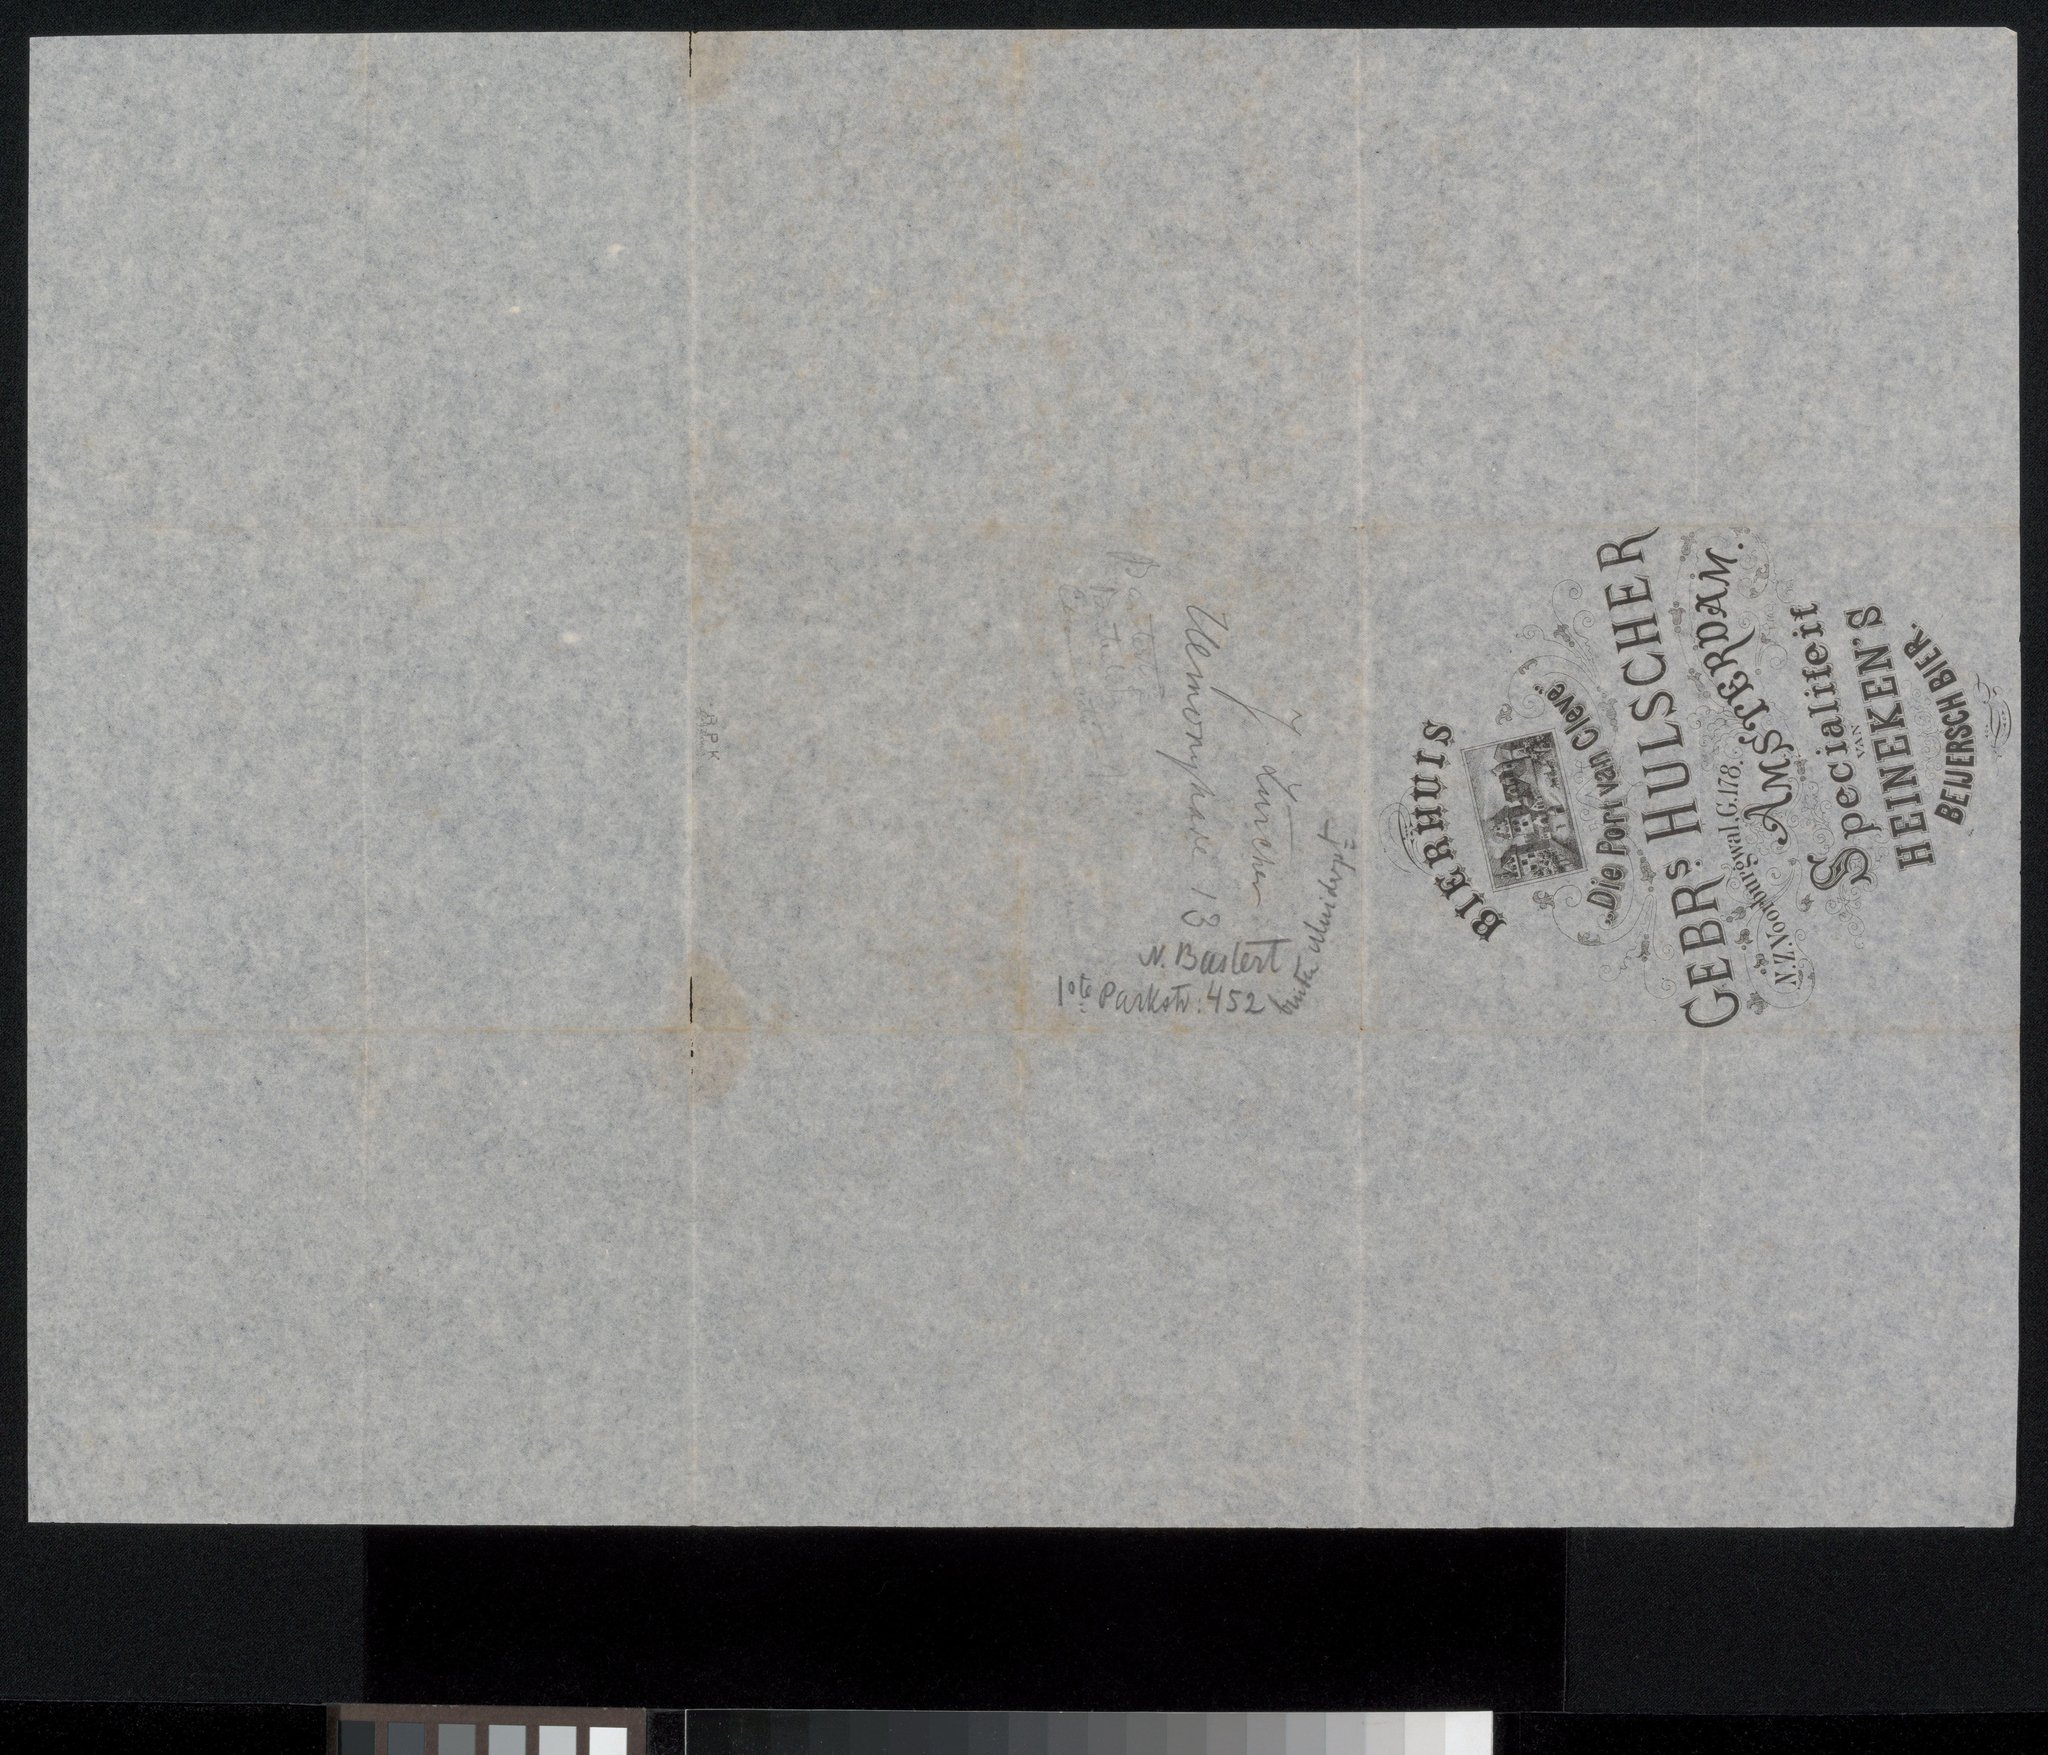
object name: aantekening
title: Aantekening uit archief Philip Zilcken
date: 1867-1905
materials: paper, pencil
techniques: printing, writing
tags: nicolaas bastert, the hague, painter, draughtsman, philip zilcken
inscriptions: collector's mark: ‘RPK’